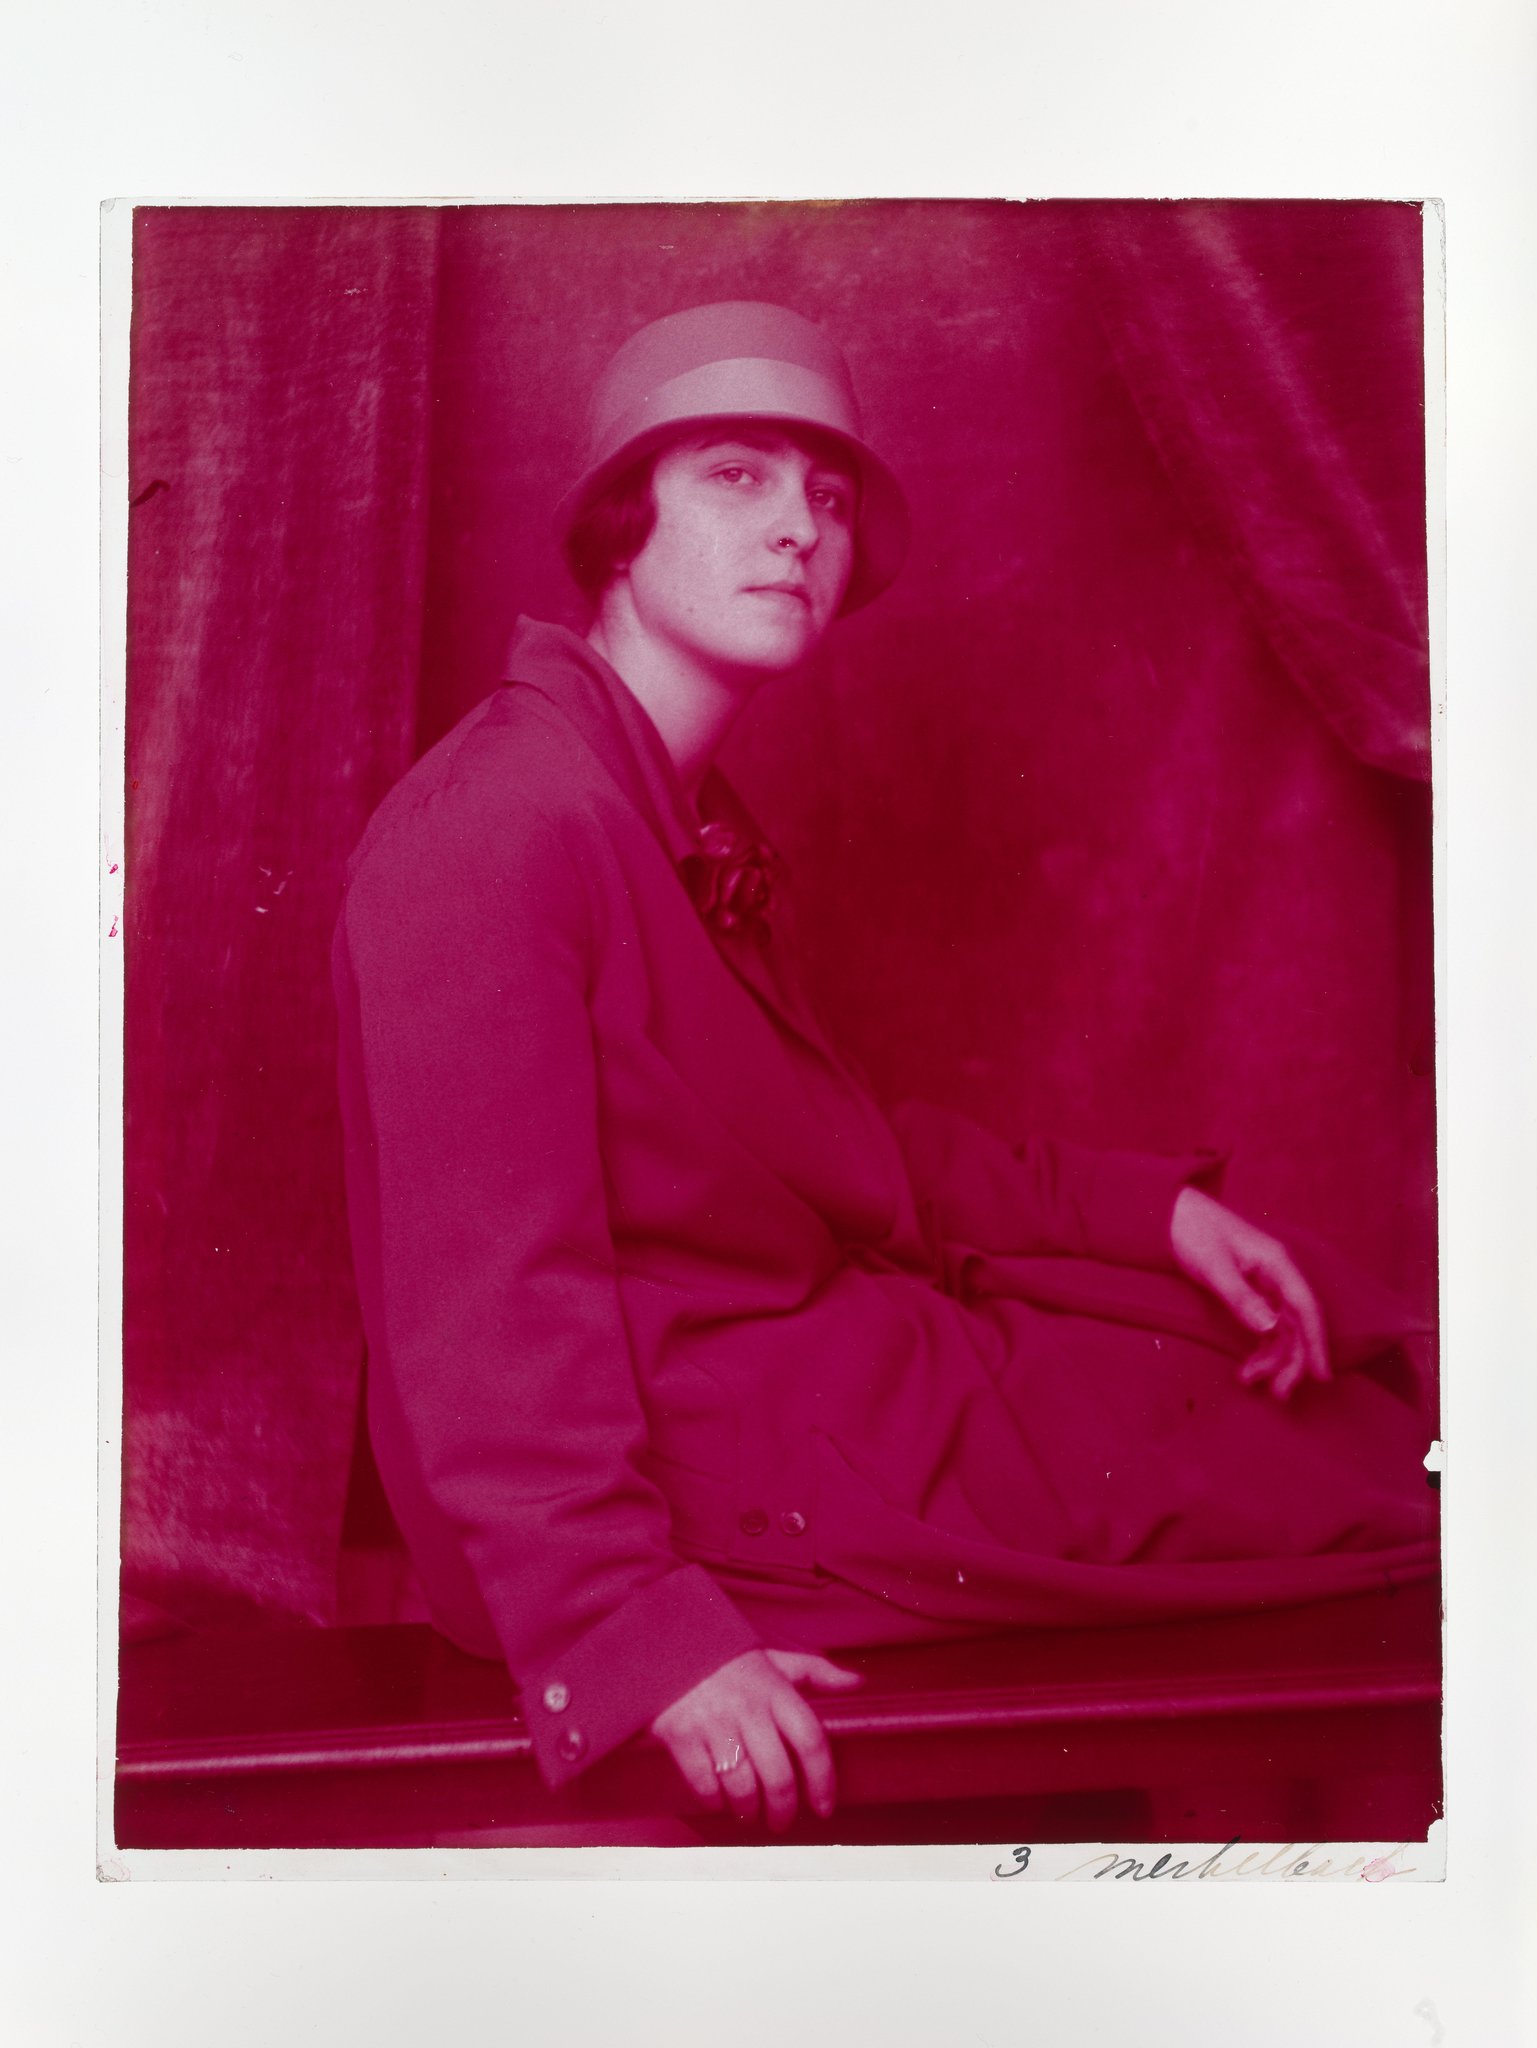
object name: photograph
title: Portret van Mies Rosenboom-Merkelbach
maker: jacob merkelbach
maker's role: fotograaf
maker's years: 1877-1942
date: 1920-1930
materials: glass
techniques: jos-pé print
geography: amsterdam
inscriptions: signature and date